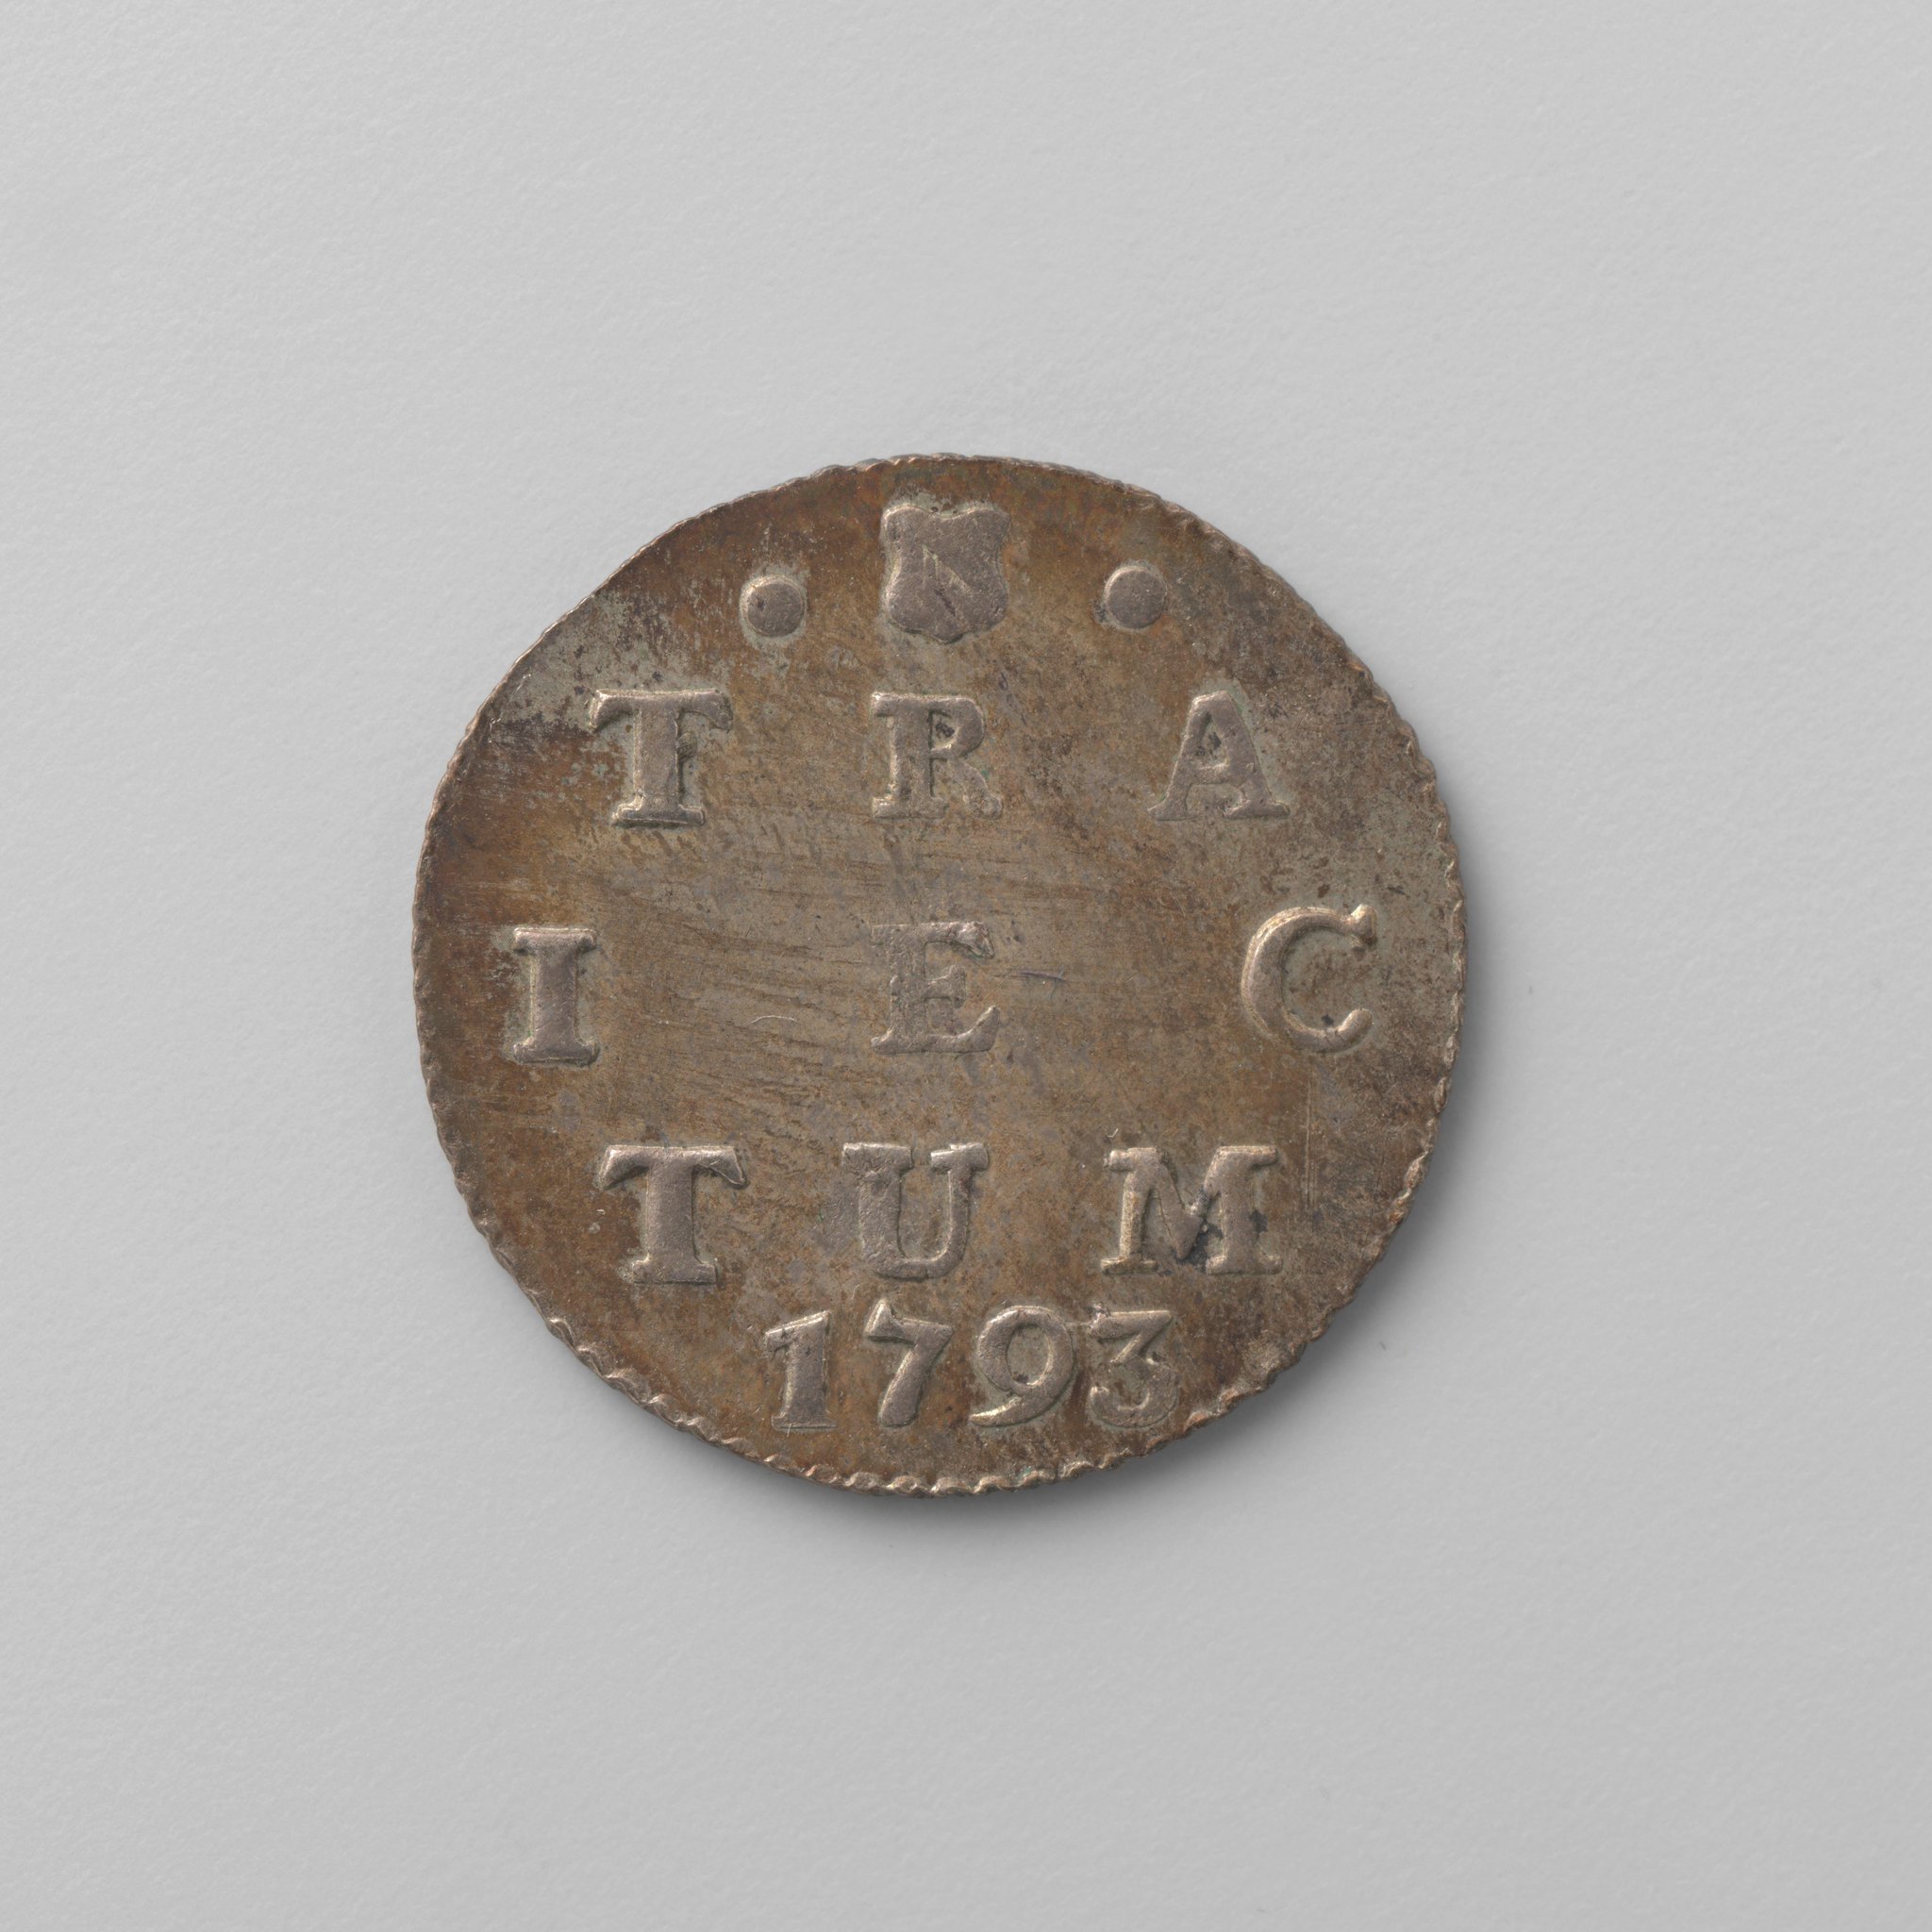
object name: coin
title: Utrechtse dubbele stuiver, 1790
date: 1790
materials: silver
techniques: striking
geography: utrecht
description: Zilveren munt. Voorzijde: tussen waarde-aanduiding 2 S gekroond enkelveldig wapenschild van Utrecht. Keerzijde: onder muntteken tussen twee puntjes opschrift: provincienaam in drie regels, daaronder jaartal. Kabelrand.